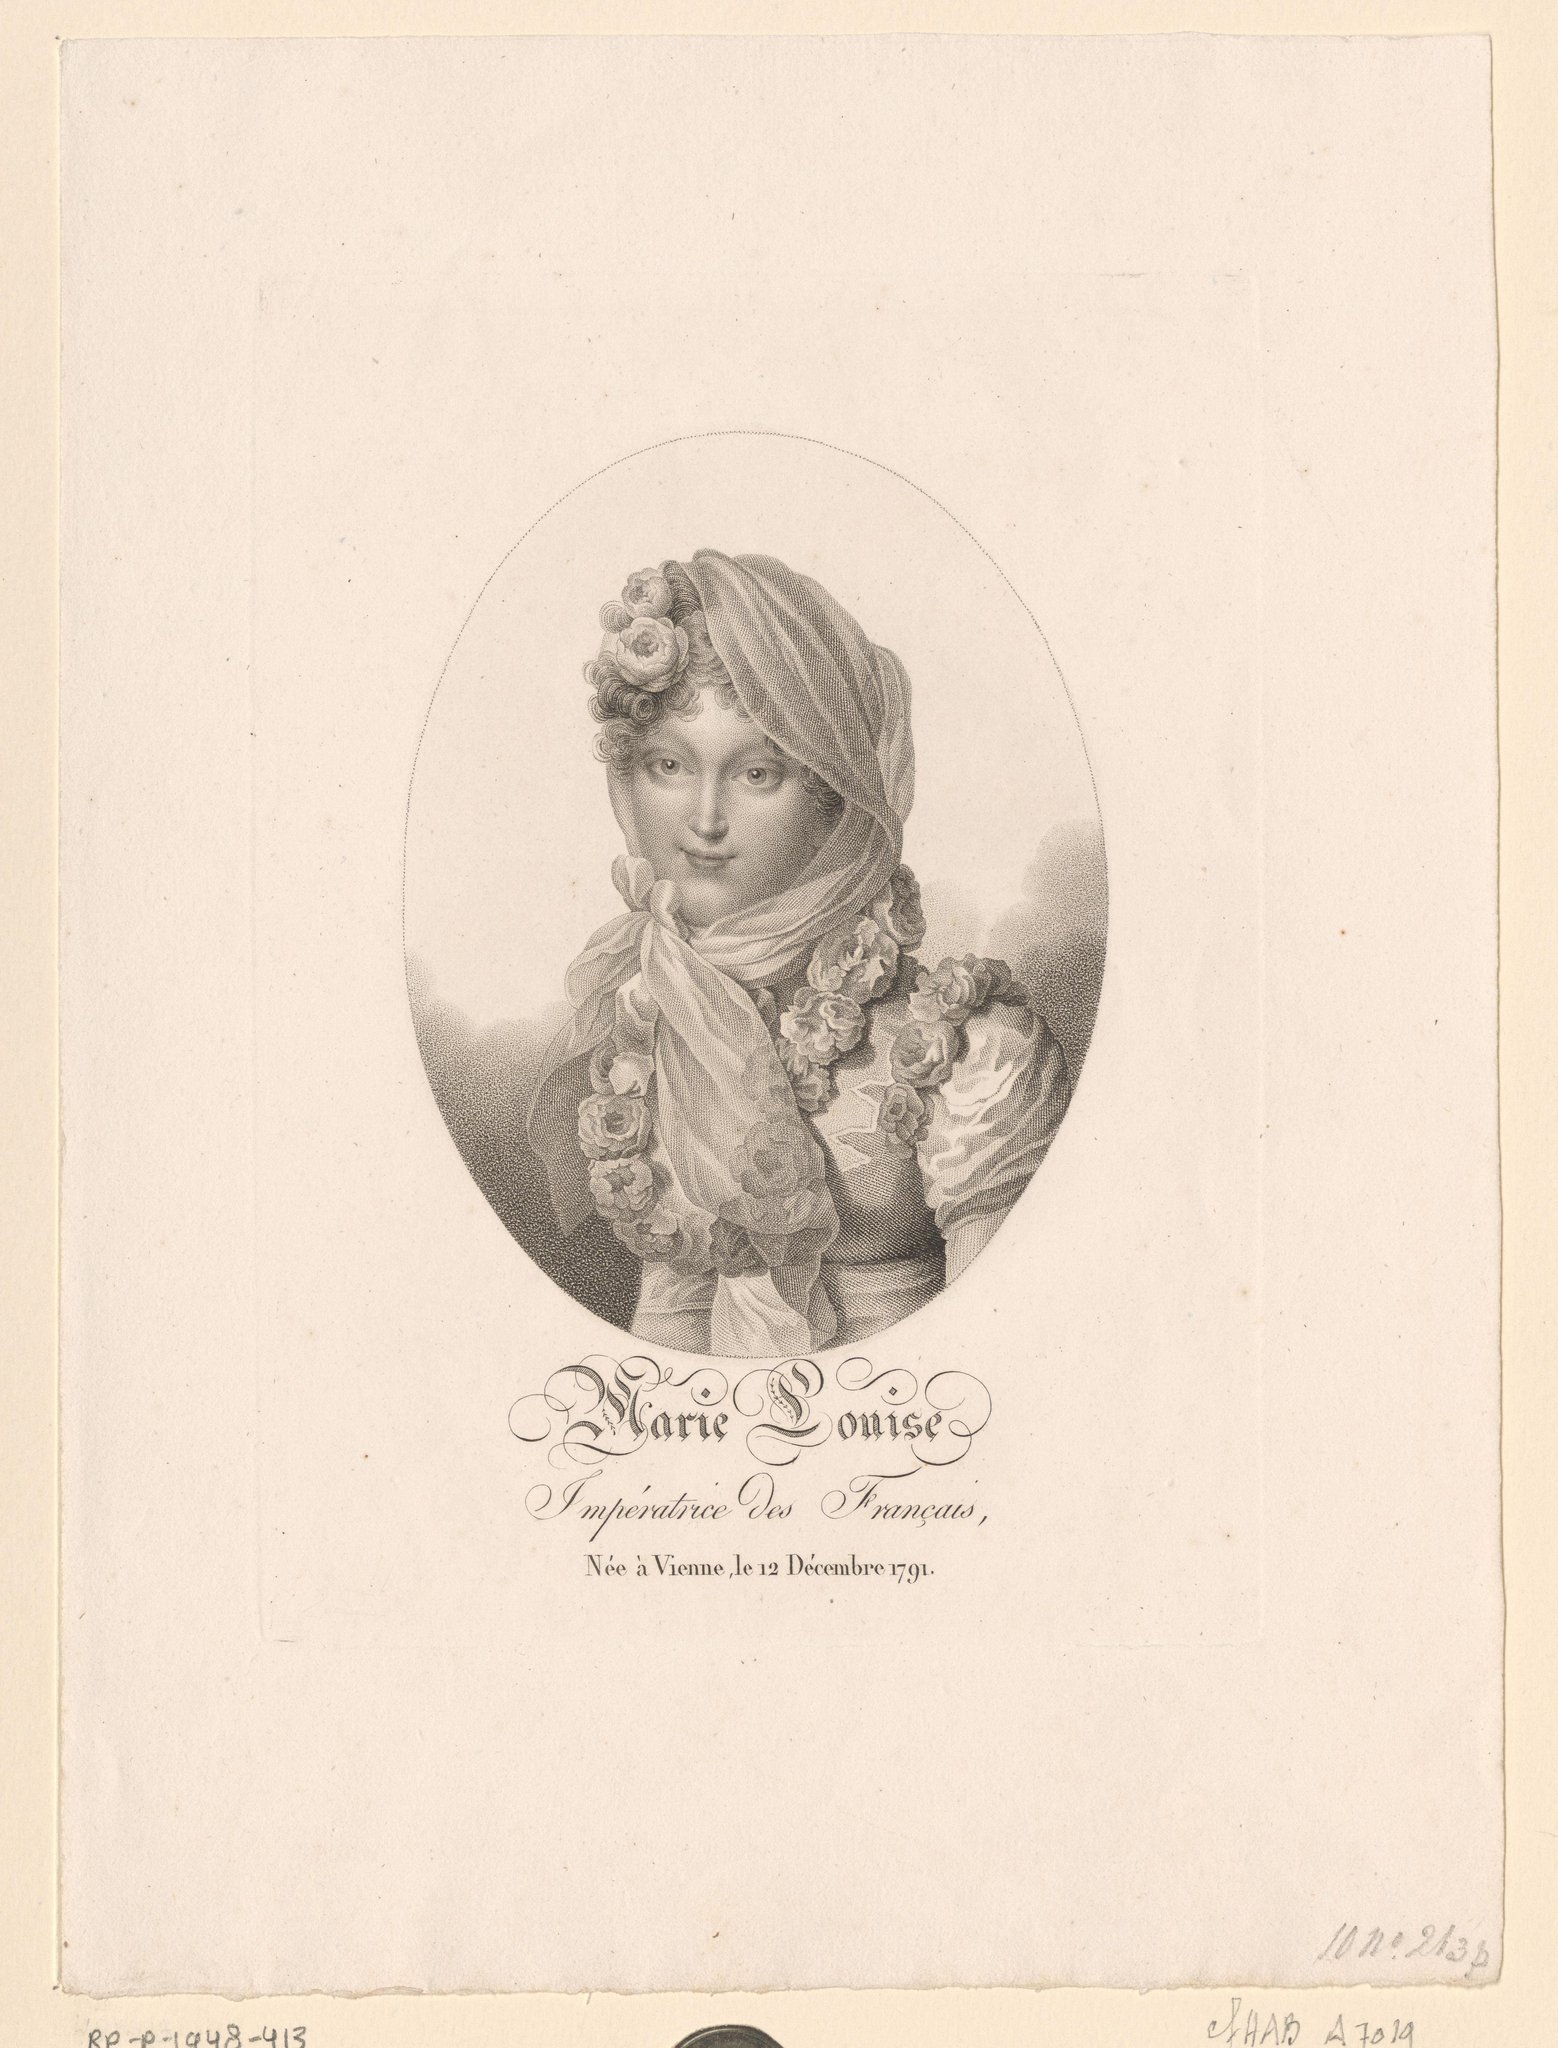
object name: print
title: Portret van Marie Louise van Oostenrijk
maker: Anonymous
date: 1810-1815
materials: paper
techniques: stippling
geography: france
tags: vienna, marie louise van oostenrijk (keizerin der fransen), historical persons - bb - woman, emperor - bb - female ruler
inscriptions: collector's mark: Lugt 2228